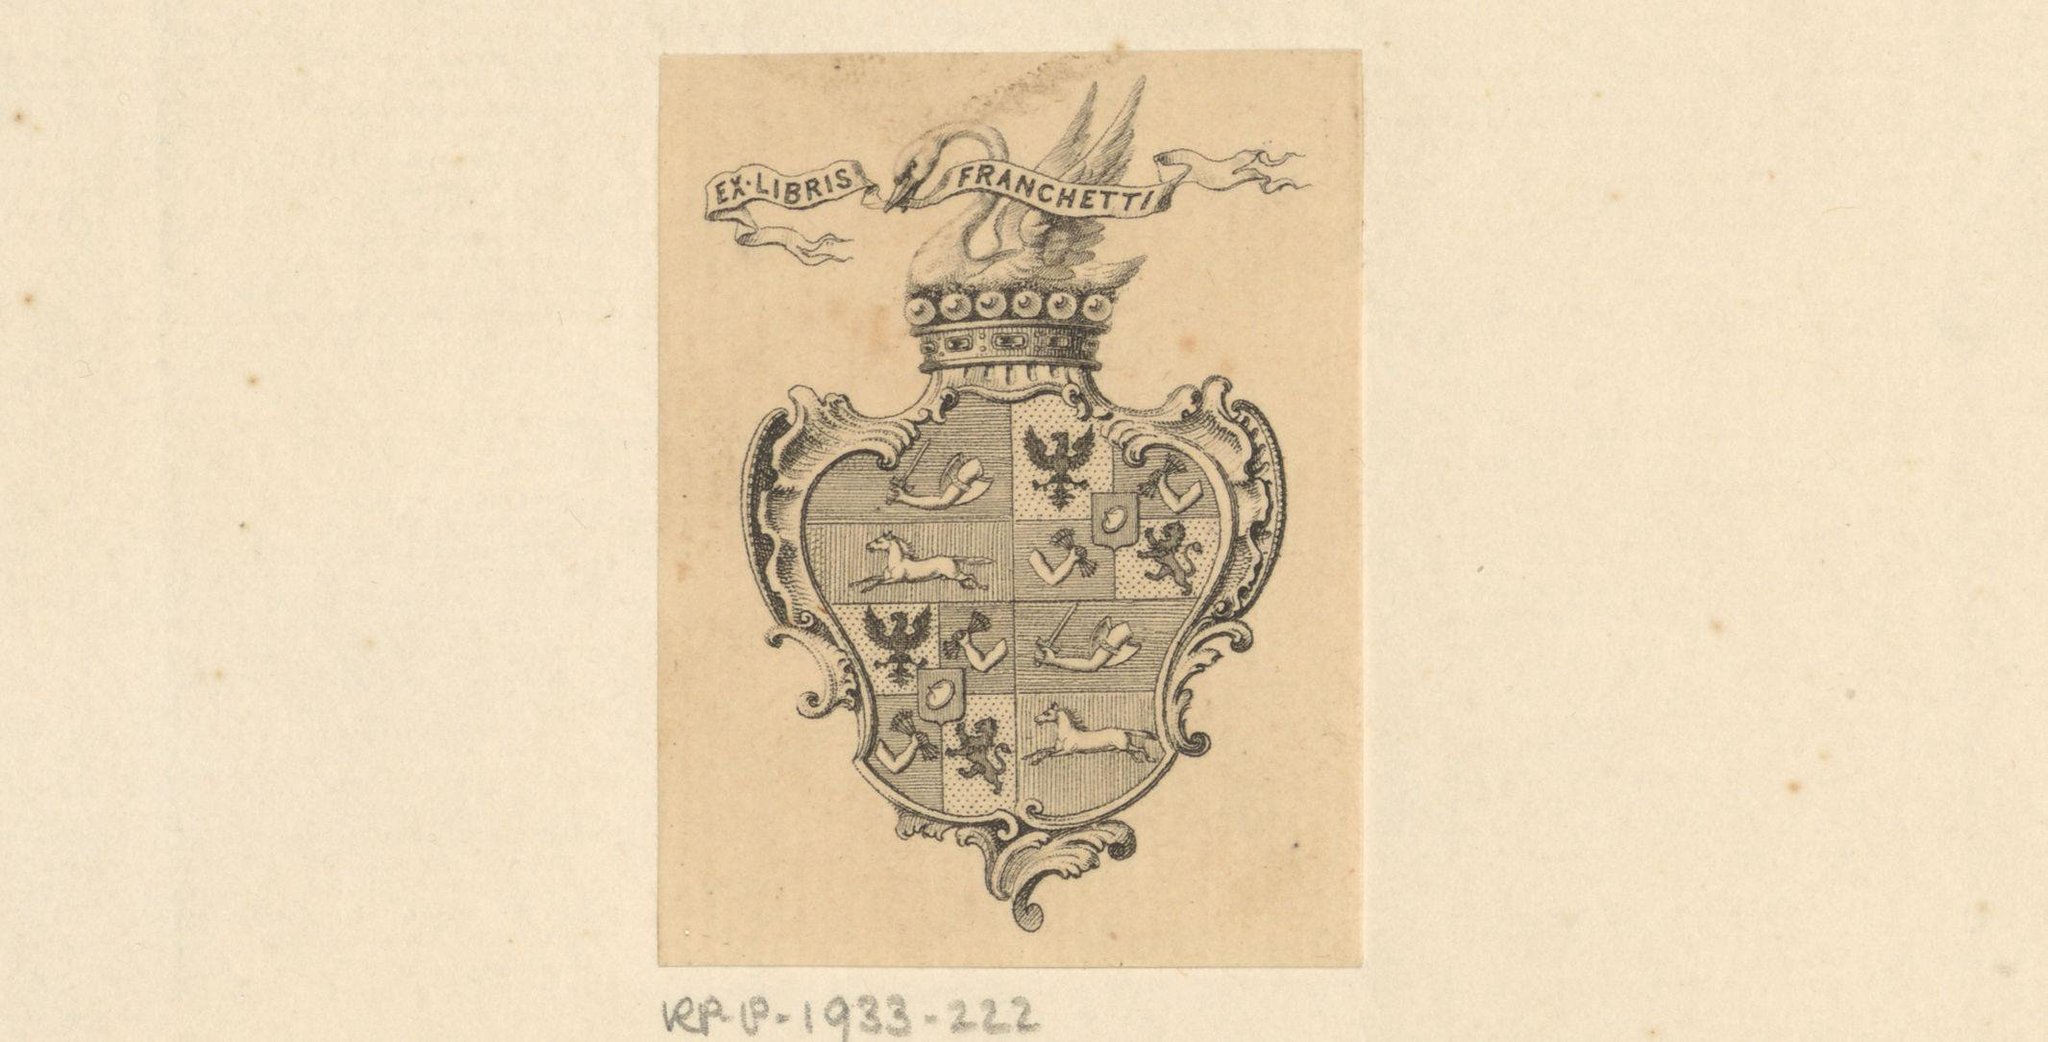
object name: bookplate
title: Ex libris van Franchetti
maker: Anonymous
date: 1800-1900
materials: paper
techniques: engraving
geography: italy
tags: water-birds: swan, armorial bearing, heraldry